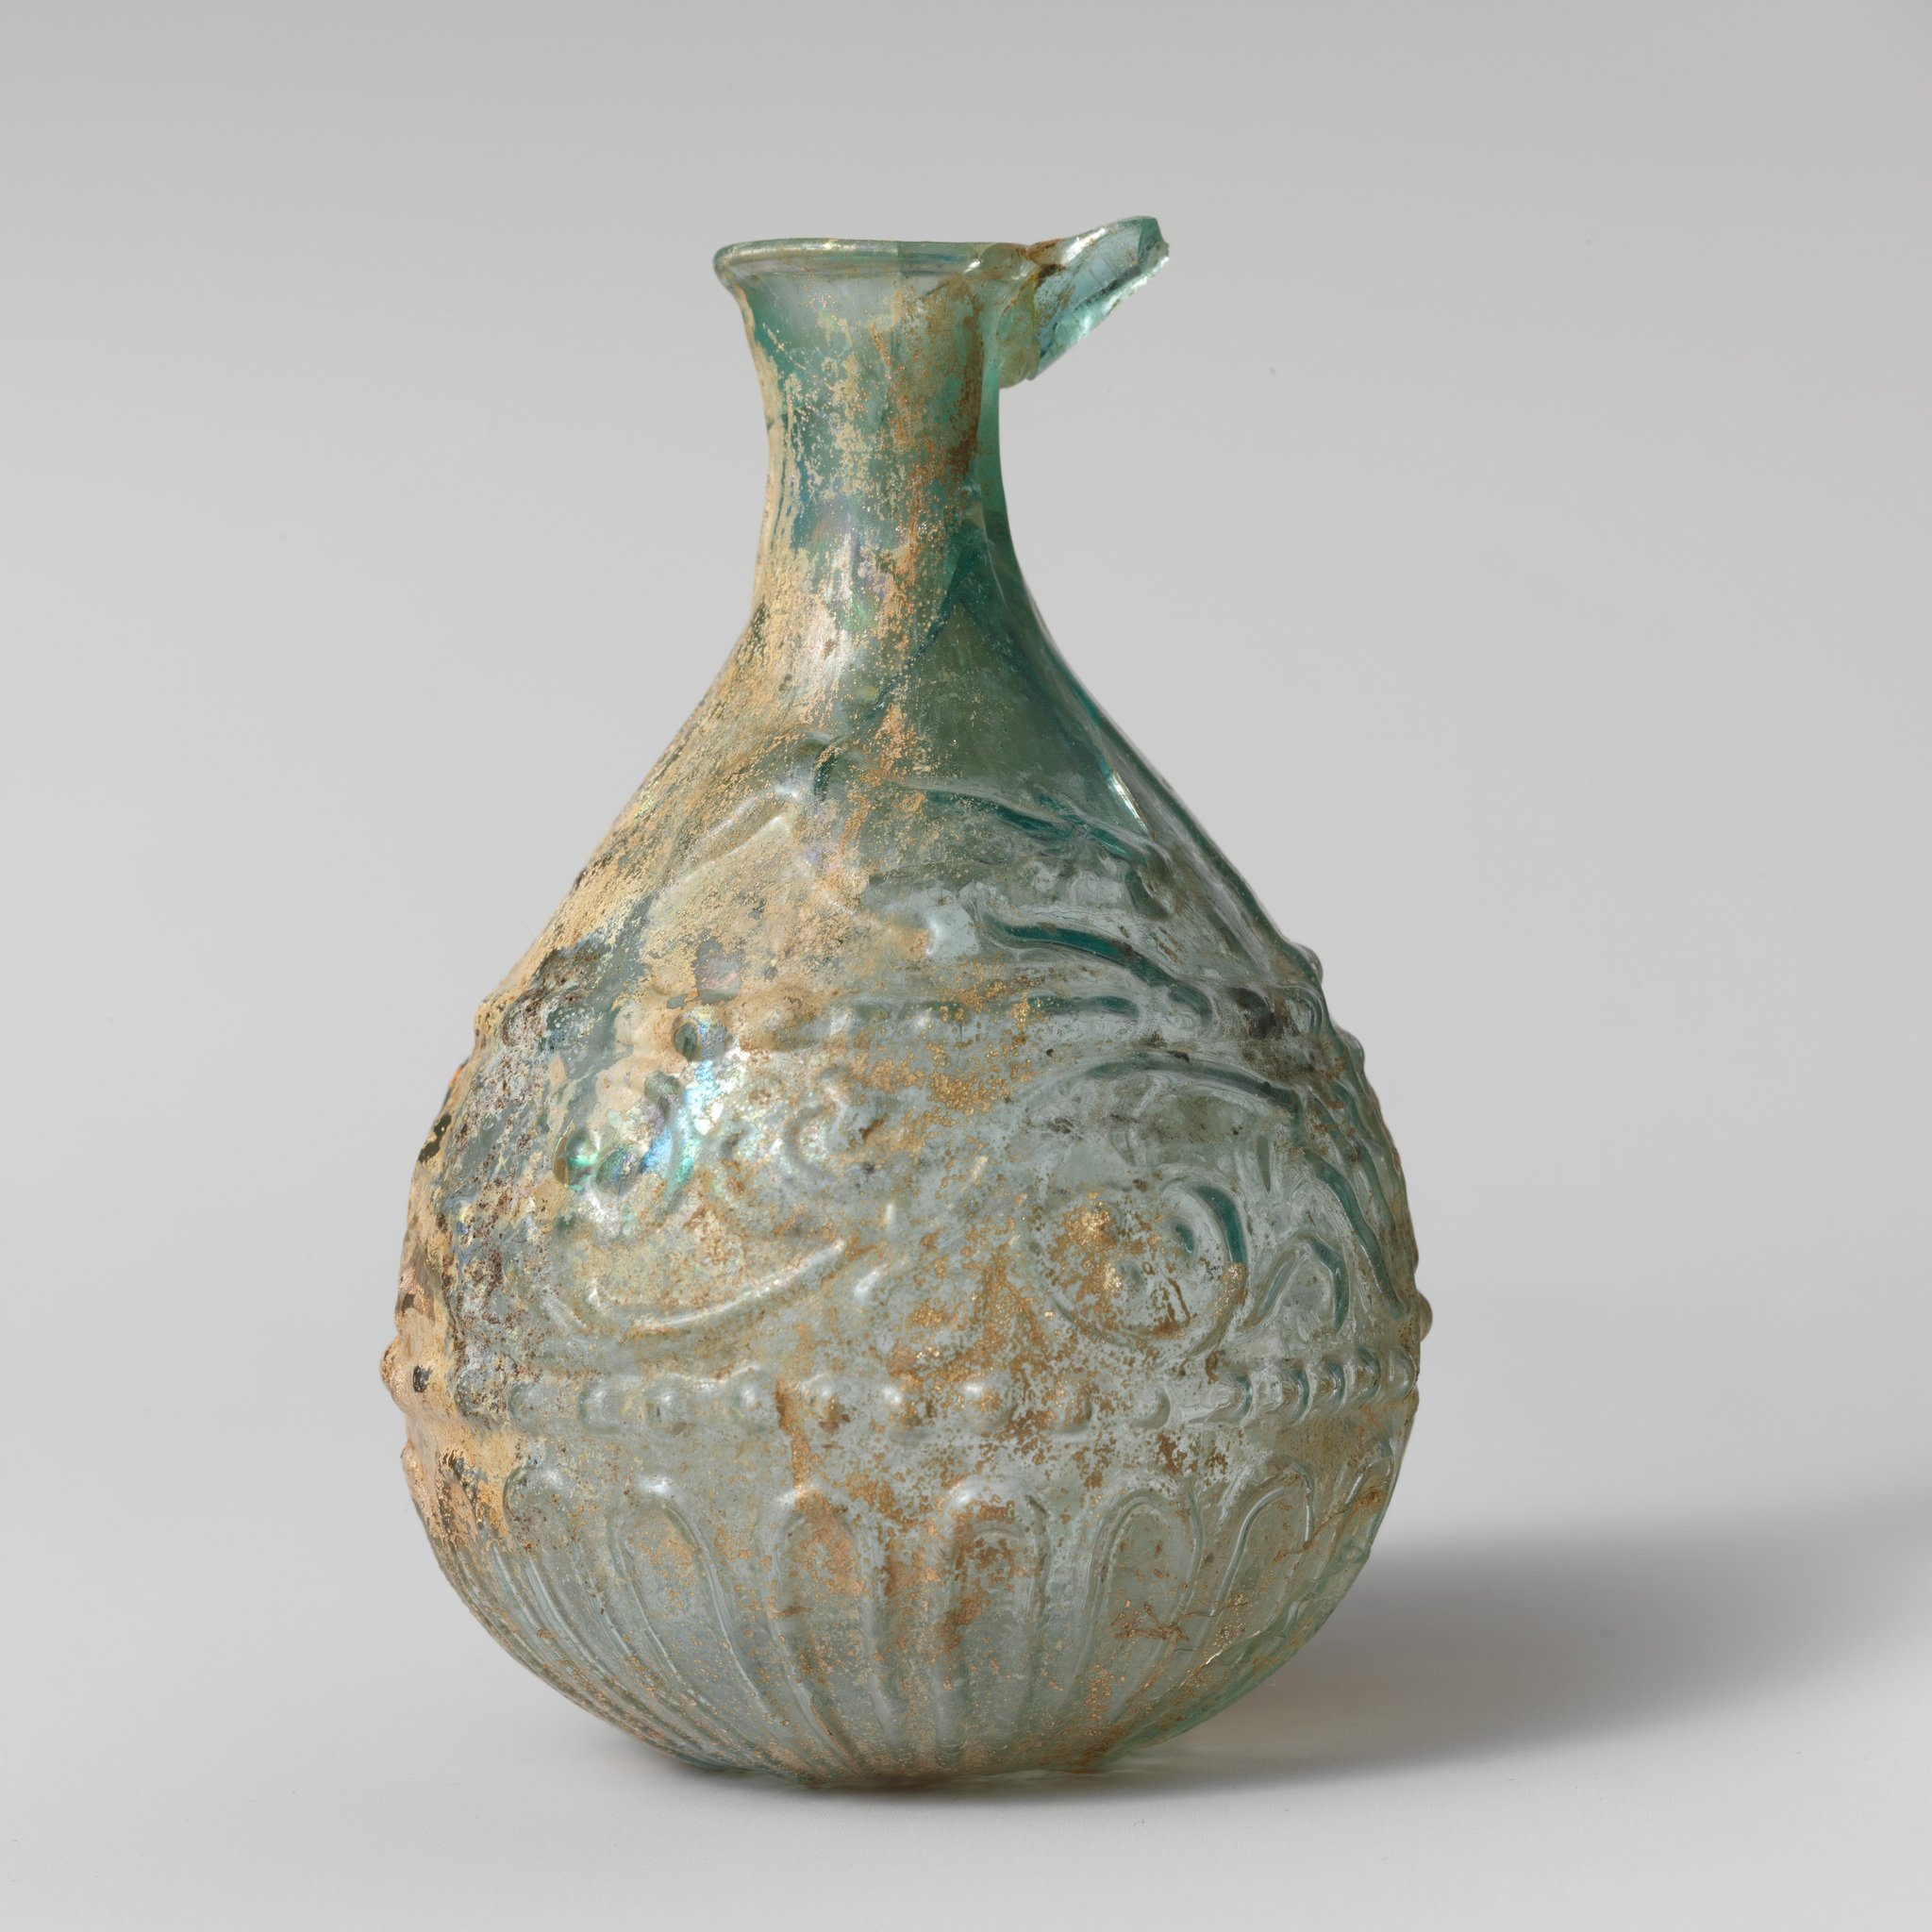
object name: bottle, one handled, hunt and scroll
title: Glass hunt-and-scroll bottle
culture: roman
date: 1-100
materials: glass